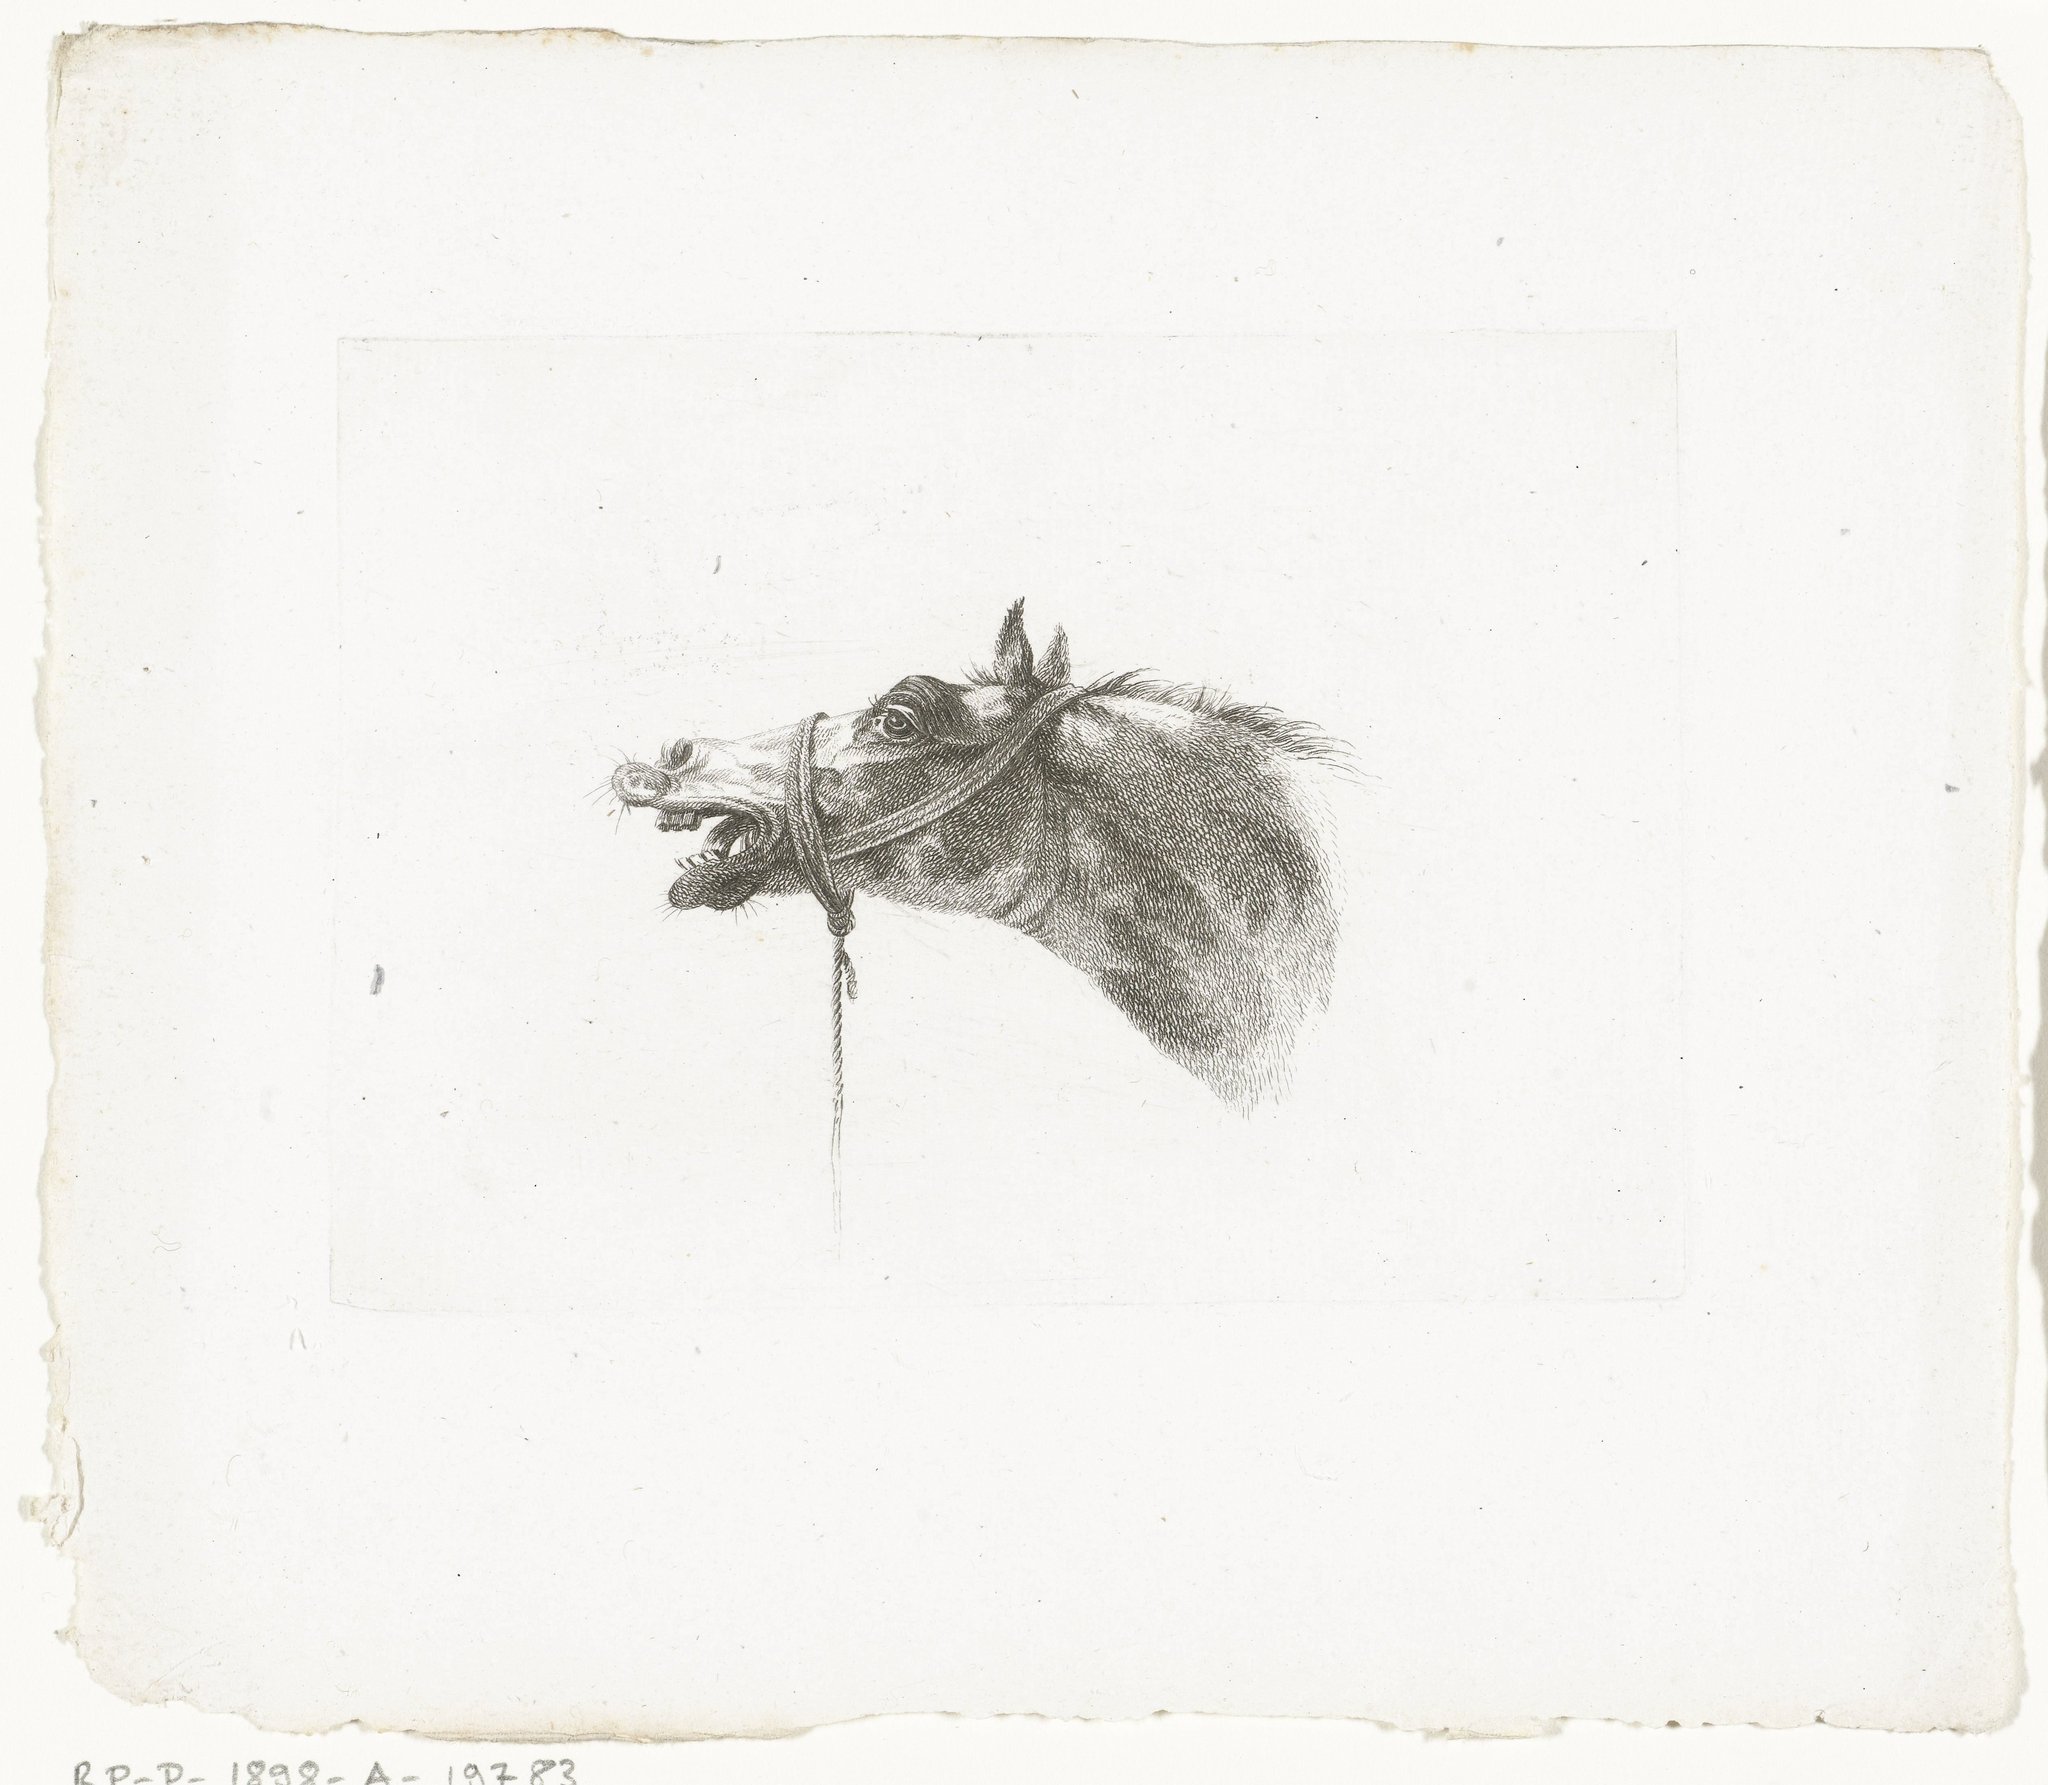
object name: print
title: Paardenhoofd met open bek, naar links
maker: joannes bemme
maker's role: print maker, printer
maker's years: 1775-1841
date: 1801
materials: paper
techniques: etching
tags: horse (+ head of an animal)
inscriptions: collector's mark: Lugt 2228